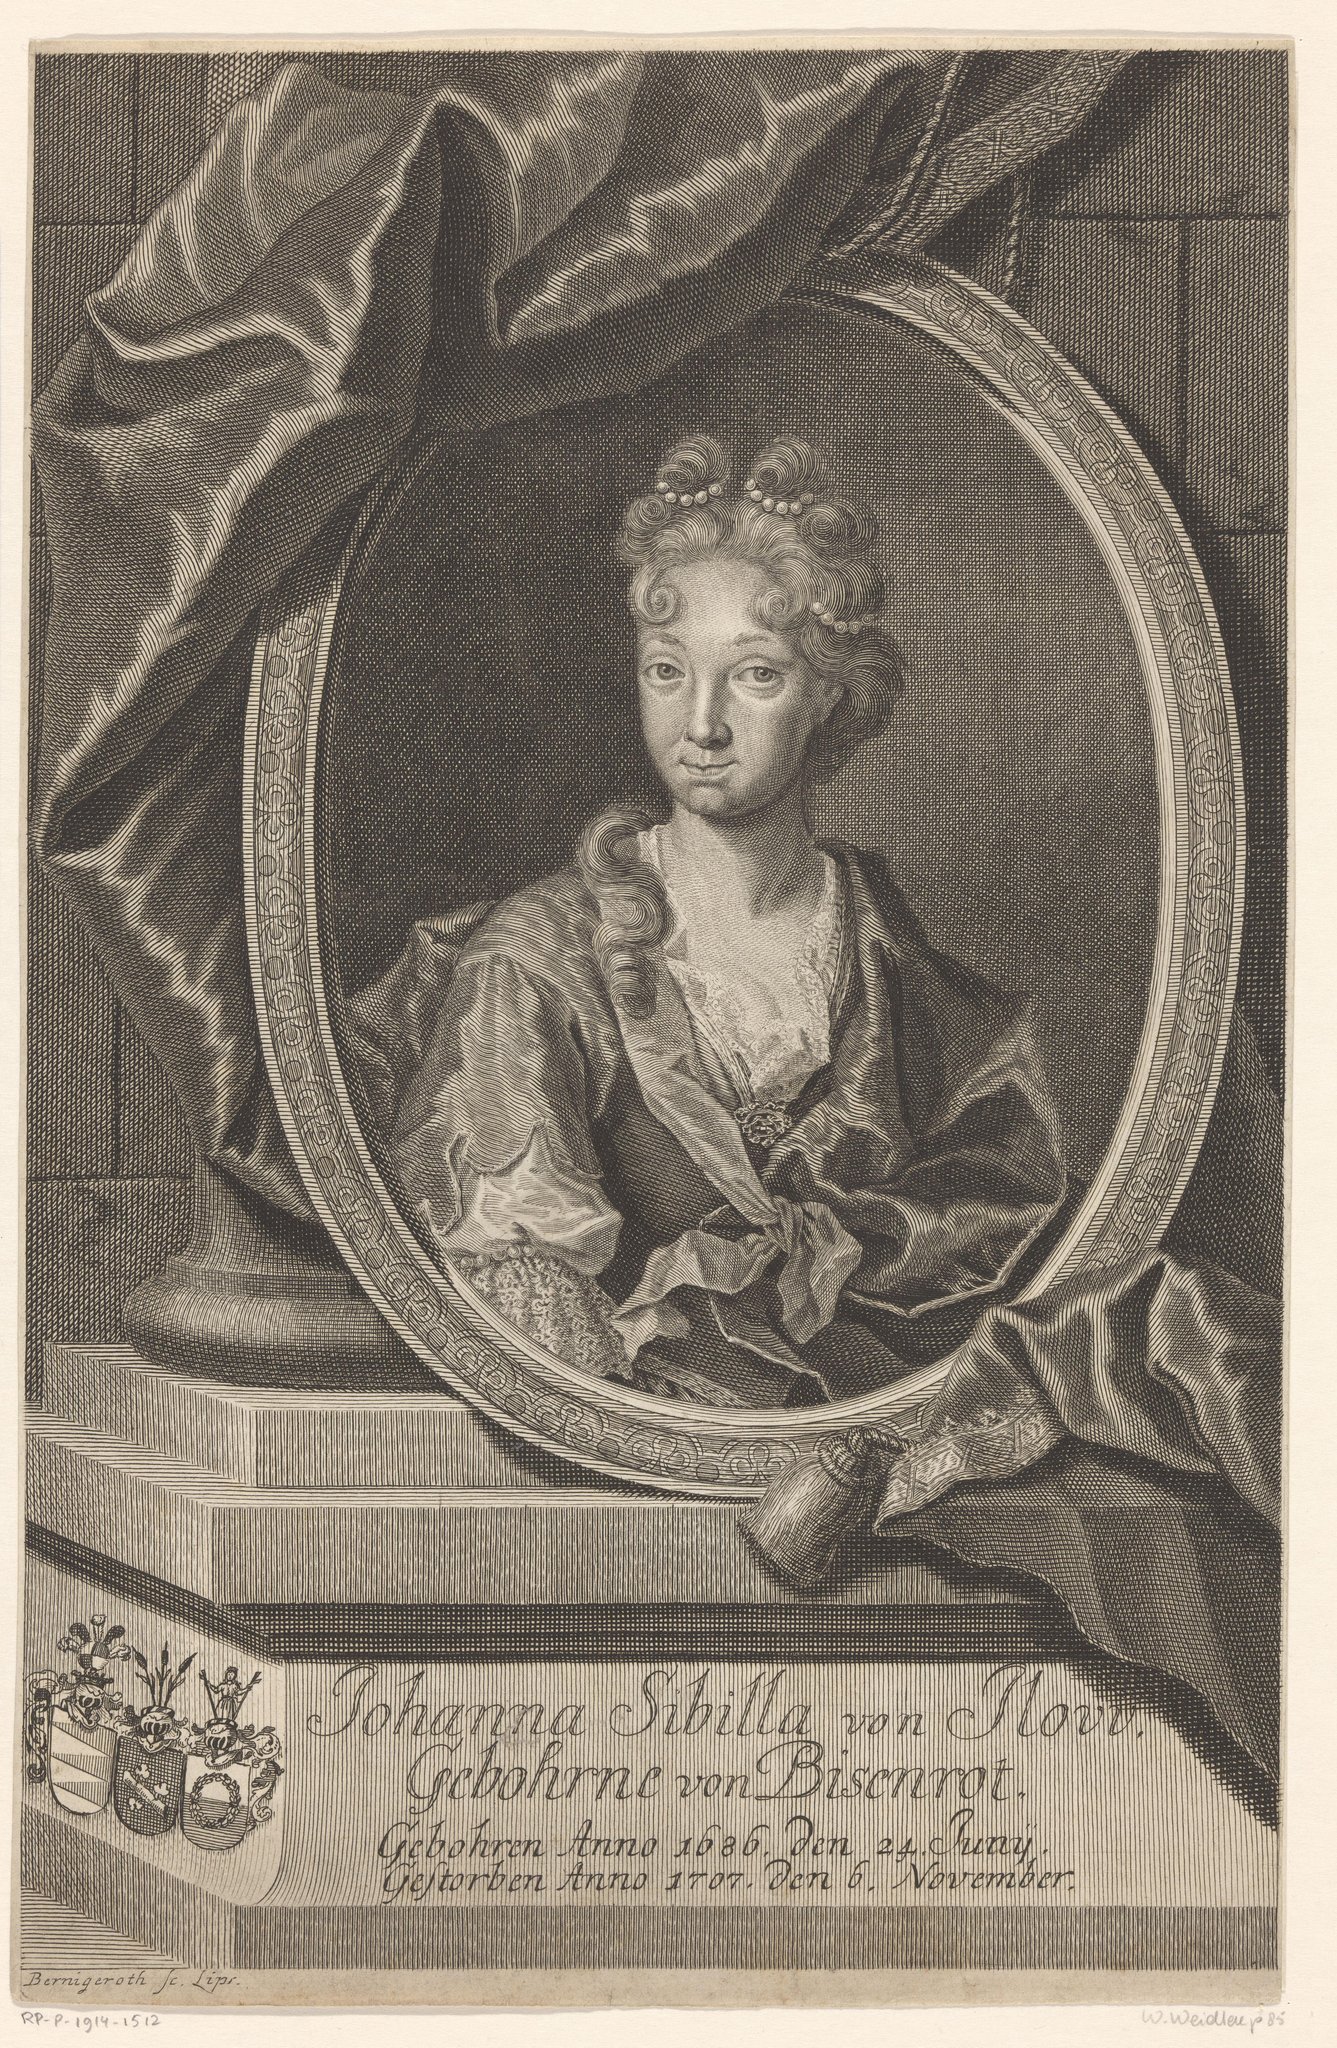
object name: print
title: Portret van Johanna Sibilla von Ilow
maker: martin bernigeroth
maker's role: print maker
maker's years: 1670-1733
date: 1707-1733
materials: paper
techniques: engraving, etching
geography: leipzig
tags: historical persons - bb - woman, armorial bearing, heraldry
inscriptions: collector's mark: Lugt 2228